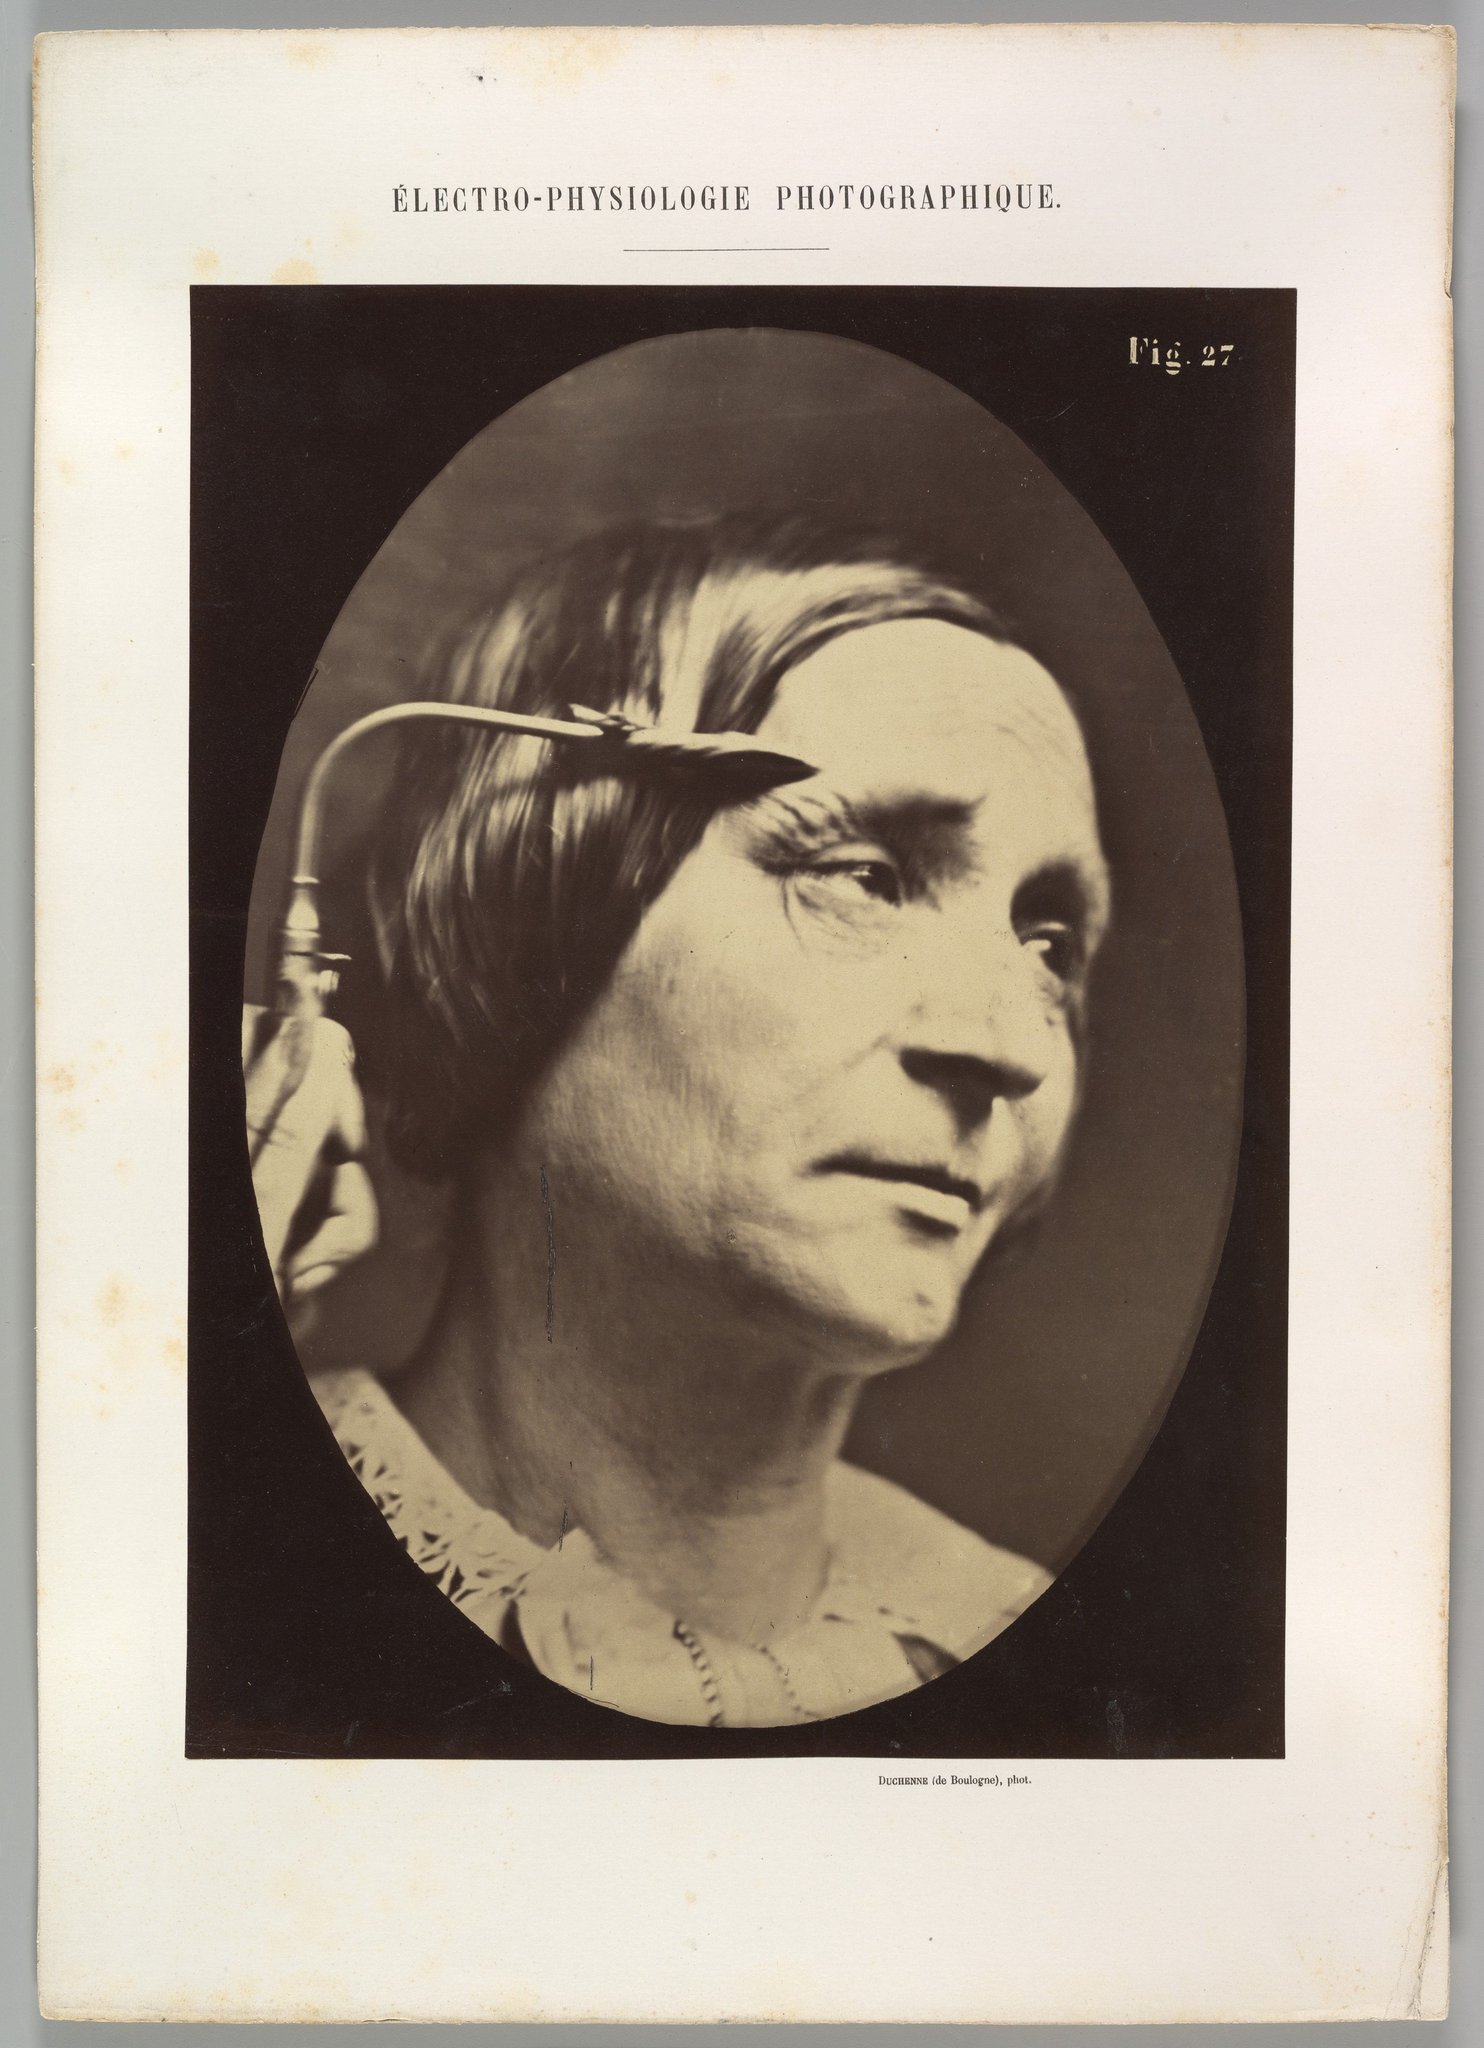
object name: photograph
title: Figure 27: Expression proportionally more pained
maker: guillaume-benjamin-amand duchenne de boulogne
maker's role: artist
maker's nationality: french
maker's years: 1806-1875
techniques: albumen silver print, glass negative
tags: science,portraits,women